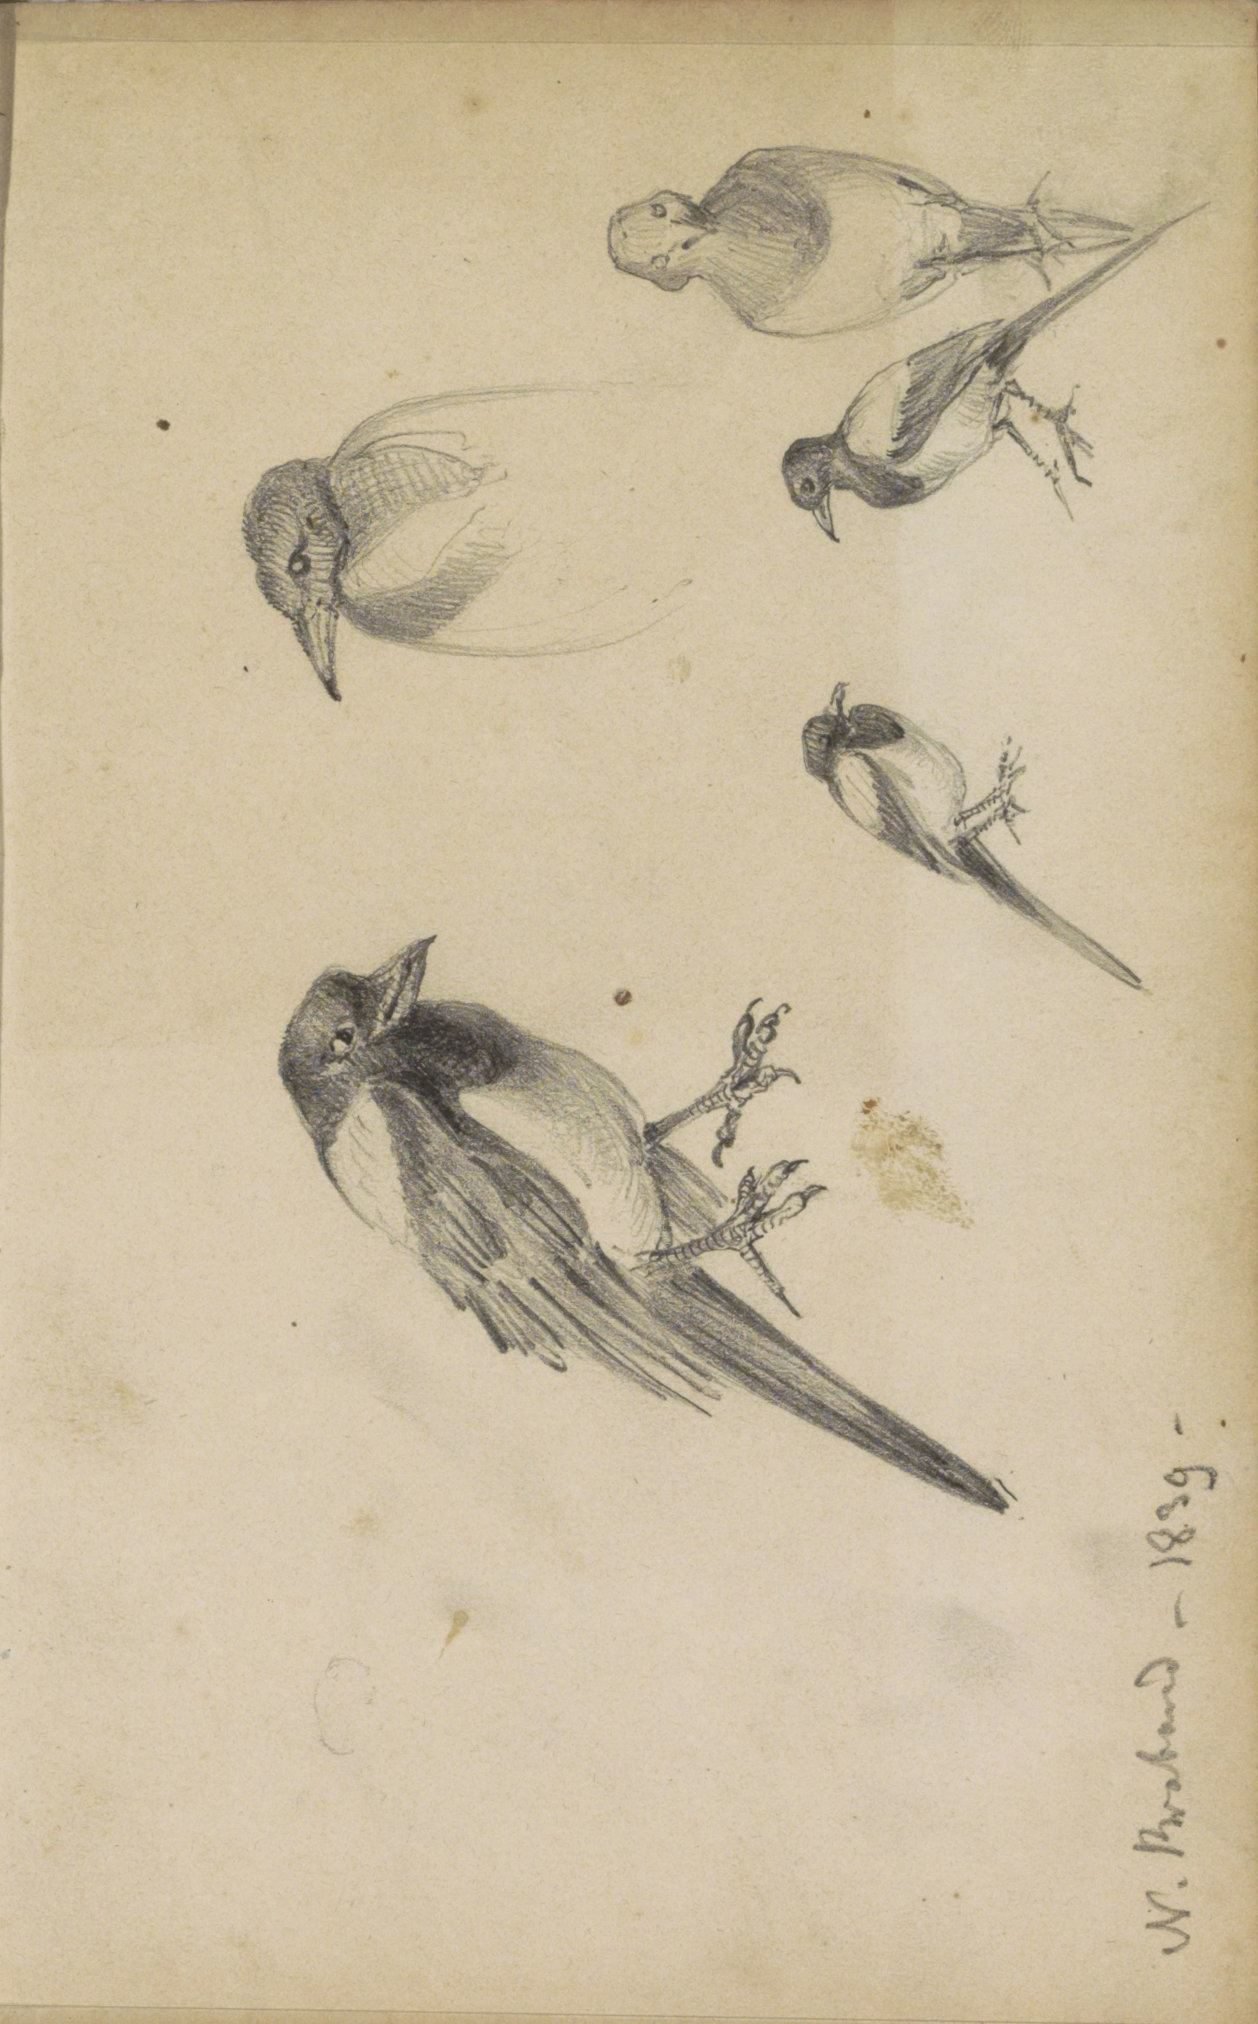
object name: sketchbook leaf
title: Eksters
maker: johannes tavenraat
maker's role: draughtsman, painter, print maker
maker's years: 1809-1881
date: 1839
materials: paper, pencil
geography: north brabant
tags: birds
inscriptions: date and inscription: ‘N. Braband - 1839-’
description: Blad 41 recto uit een schetsboek met 73 bladen.